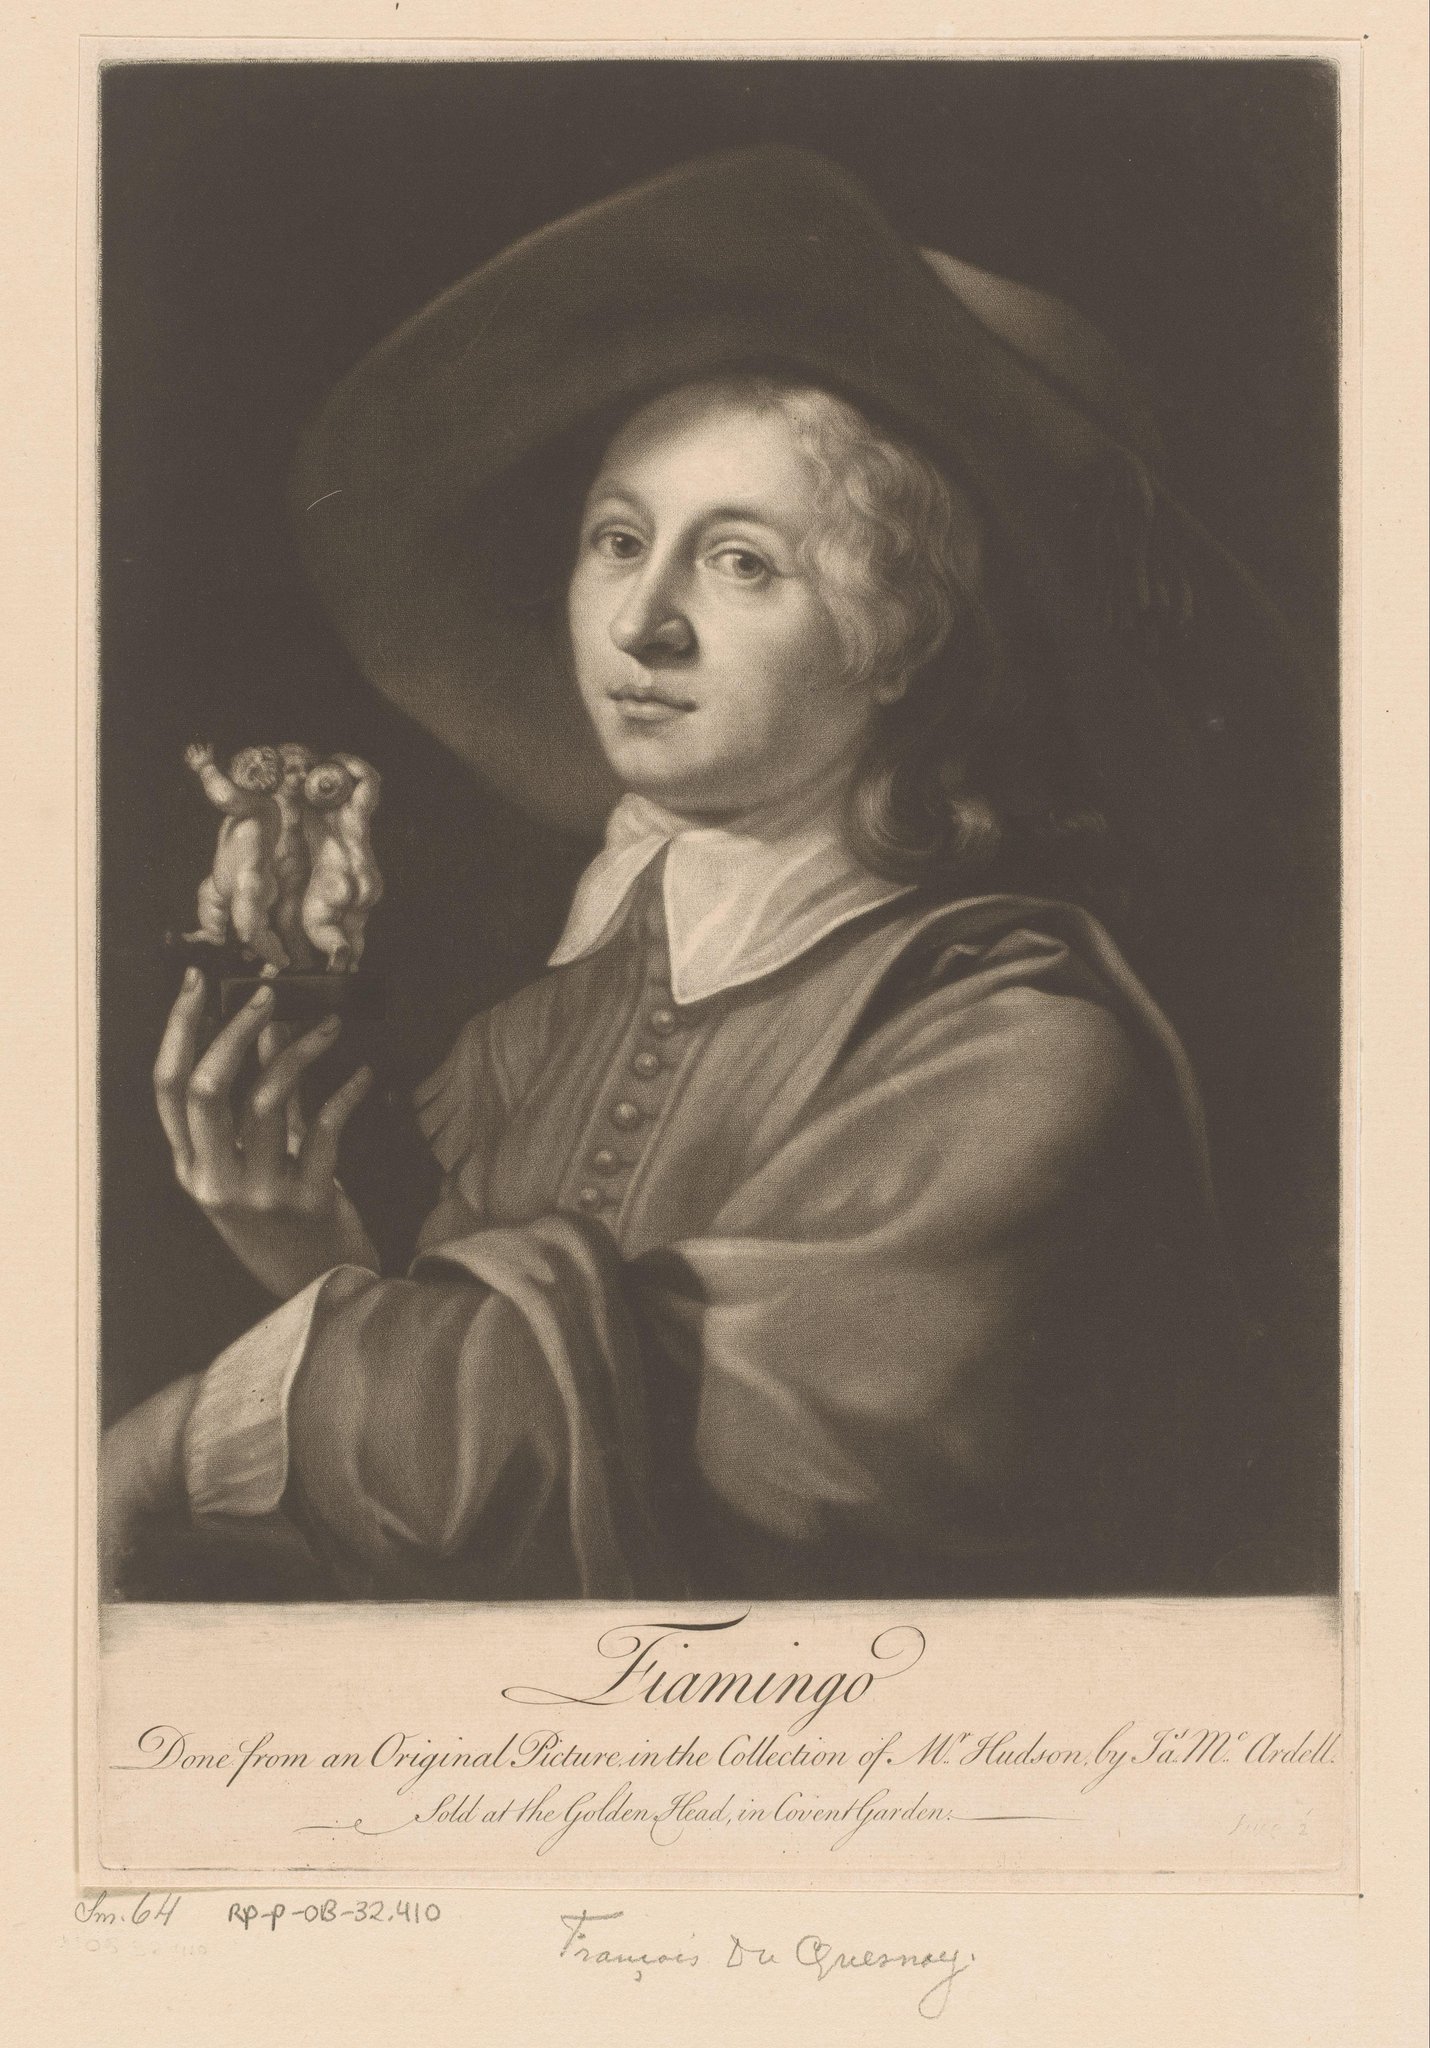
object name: print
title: Fiamingo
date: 1745-1765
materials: paper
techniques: mezzotint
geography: london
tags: brussels, draughtsman, sculptor, françois du quesnoy, portrait, self-portrait of sculptor, historical persons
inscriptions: collector's mark: Lugt 240